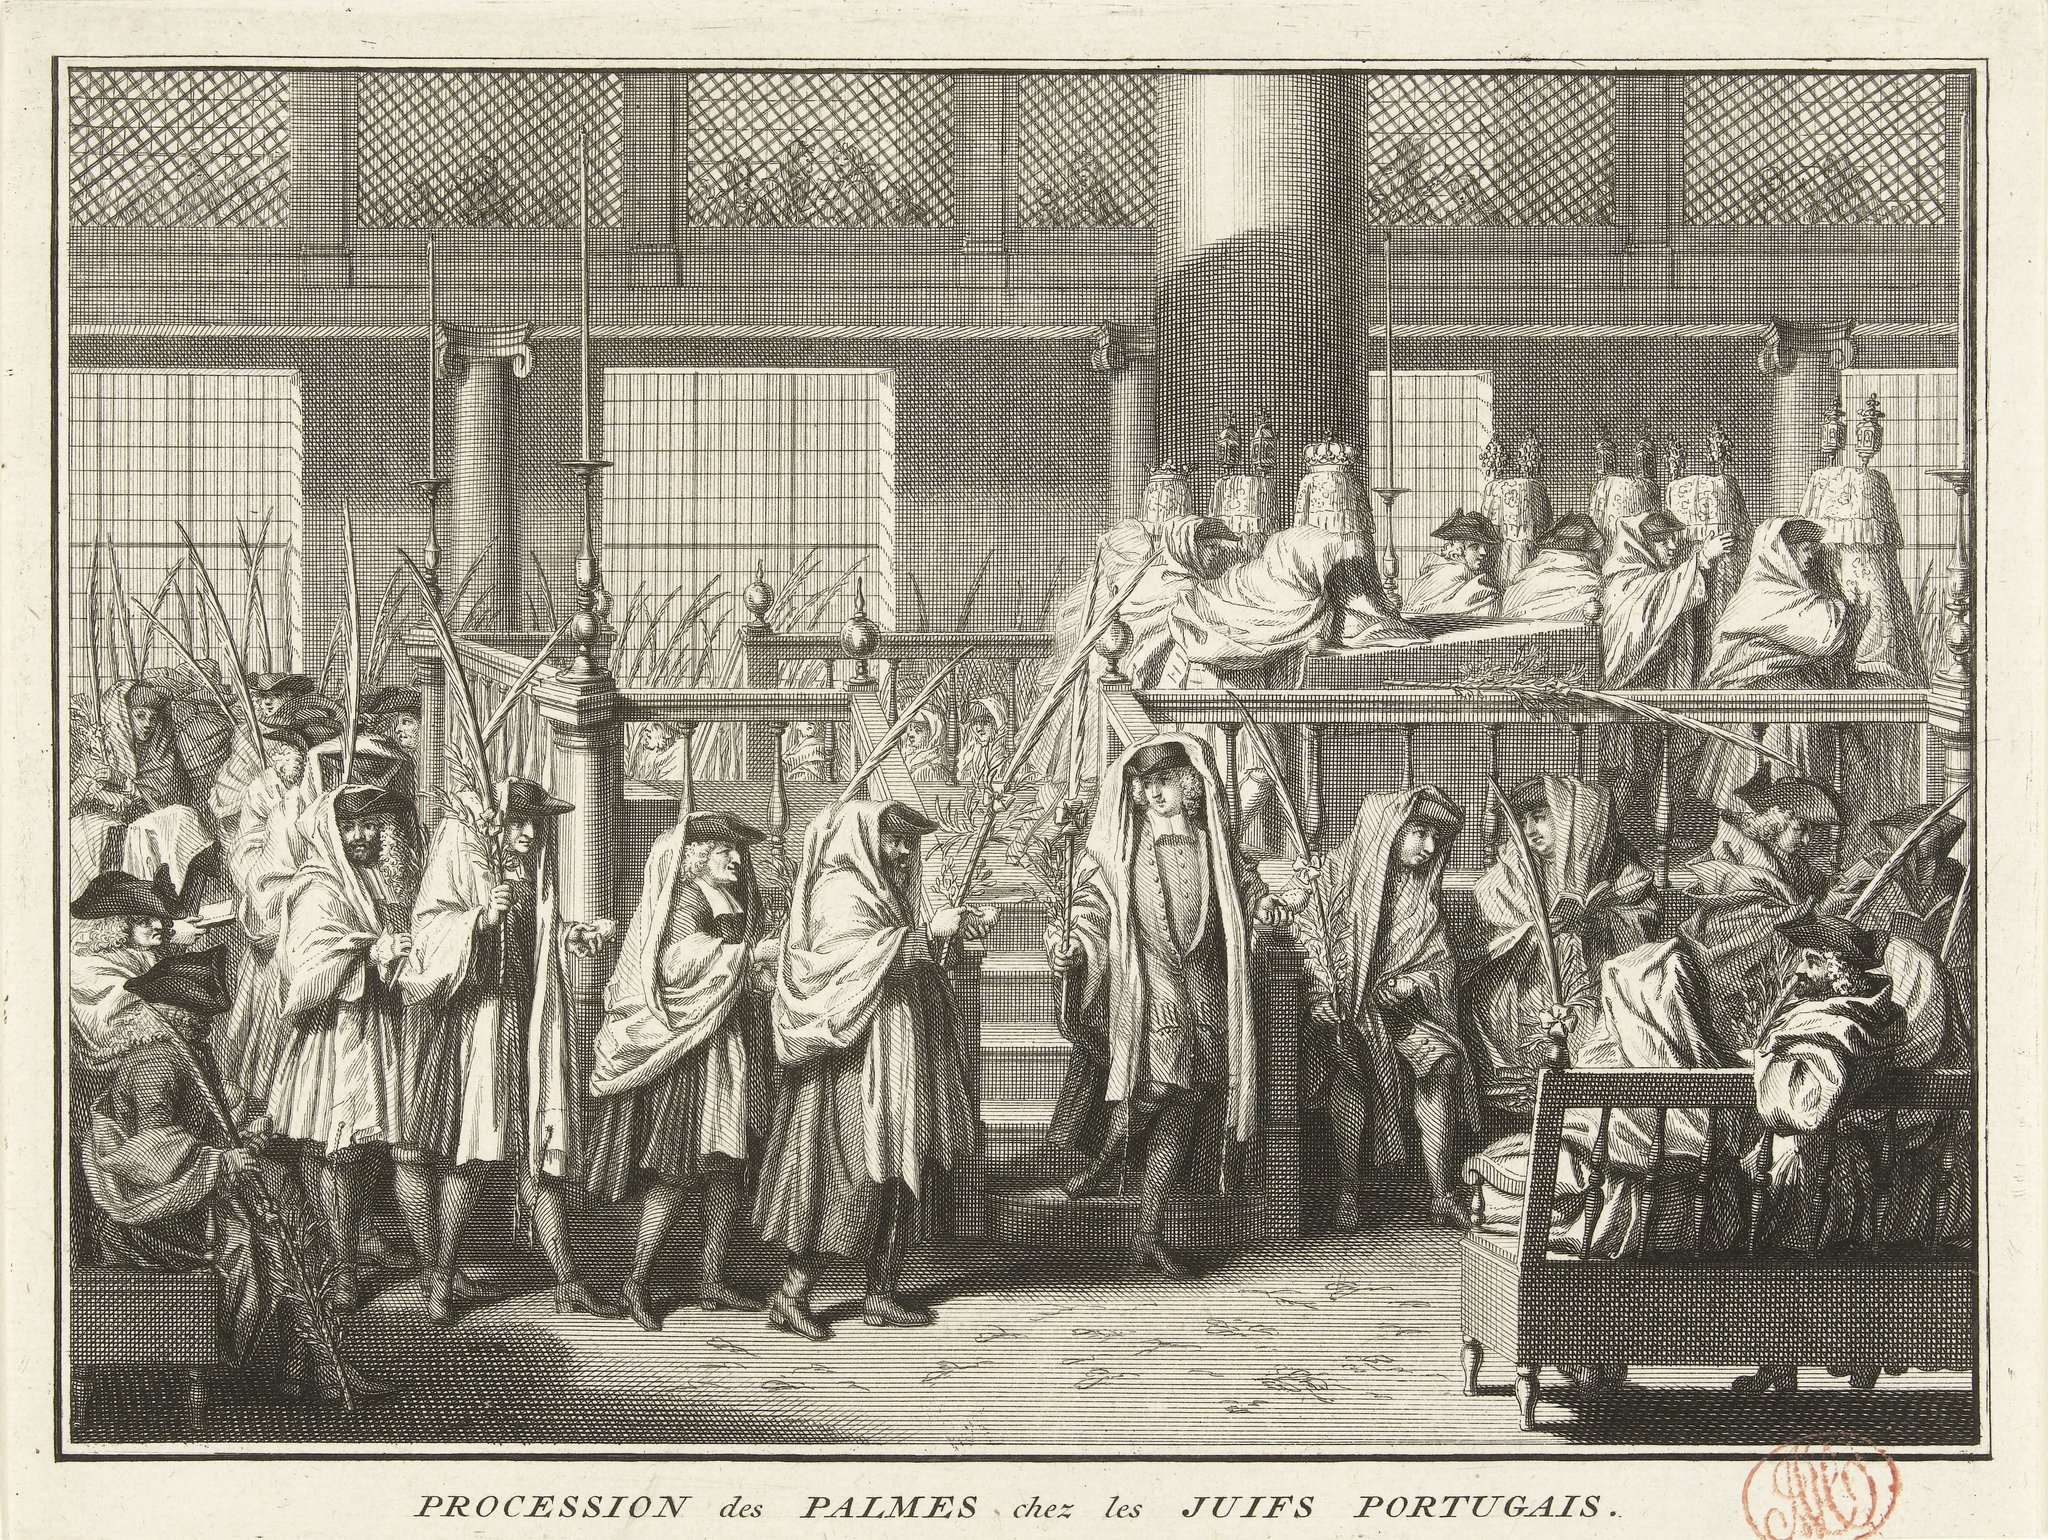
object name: print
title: Procession des Palmes chez les Juifs Portugais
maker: bernard picart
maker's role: draughtsman, print maker, publisher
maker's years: 1673-1733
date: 1720-1725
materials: paper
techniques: engraving, etching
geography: northern netherlands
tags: procession with the 'lulav' in the right hand and the 'etrog' in the left hand ~ 'sukkot'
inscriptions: collector's mark: Lugt 195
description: Gebruikt als illustratie in: A. Moubach, Naaukeurige beschryving der uitwendige godtsdienst-plichten, kerk-zeden en gewoontens van alle volkeren der waereldt : in een historisch verhaal ... in kunstige tafereelen afgemaalt. 's-Gravenhage: R.C. Alberts, 6 dln, 1727-1738. Niet in Frederik Muller; door het RPK toegevoegd nummer.